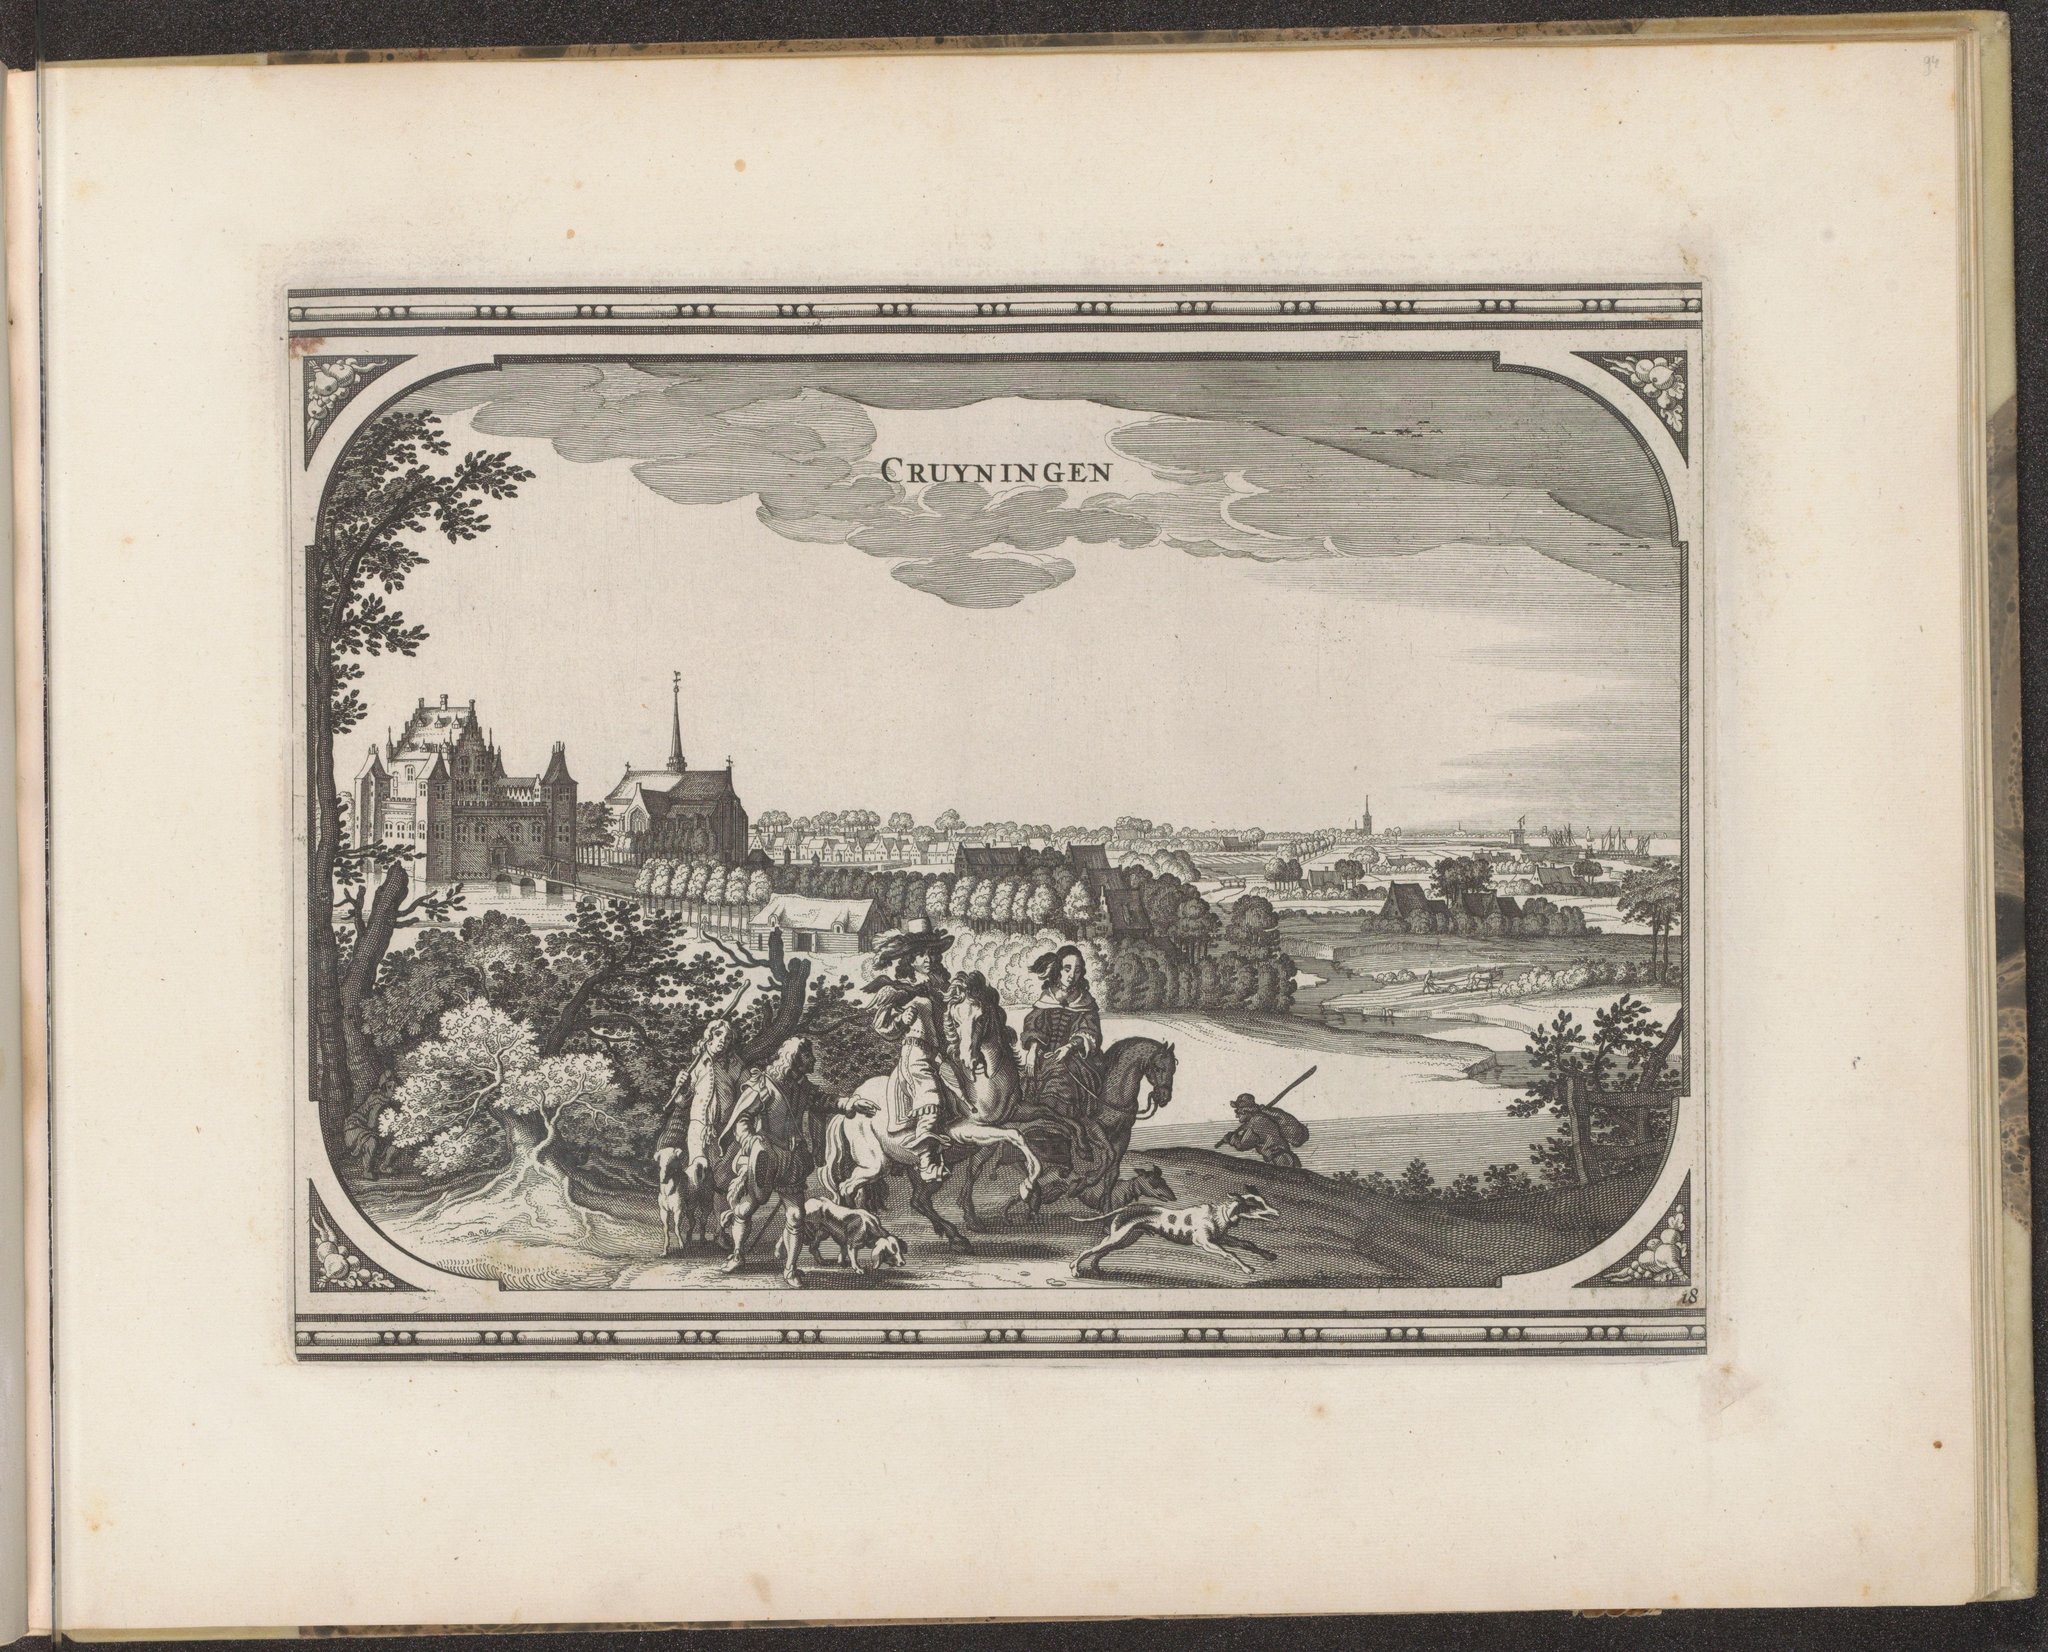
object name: album leaf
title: Theatrum praecipuarum urbium ducatus Brabantiae necnon comitatuum Flandriae et Zelandiae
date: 1662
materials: paper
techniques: etching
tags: city-view, and landscape with man-made constructions, castle, hunting, chase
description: Gezicht op Kruiningen in Zeeland. Op de voorgrond een welgesteld paar te paard. De man heeft twee jachthonden en een valk bij zich. Twee mannen wijzen het paar de weg. De prent maakt deel uit van een album.